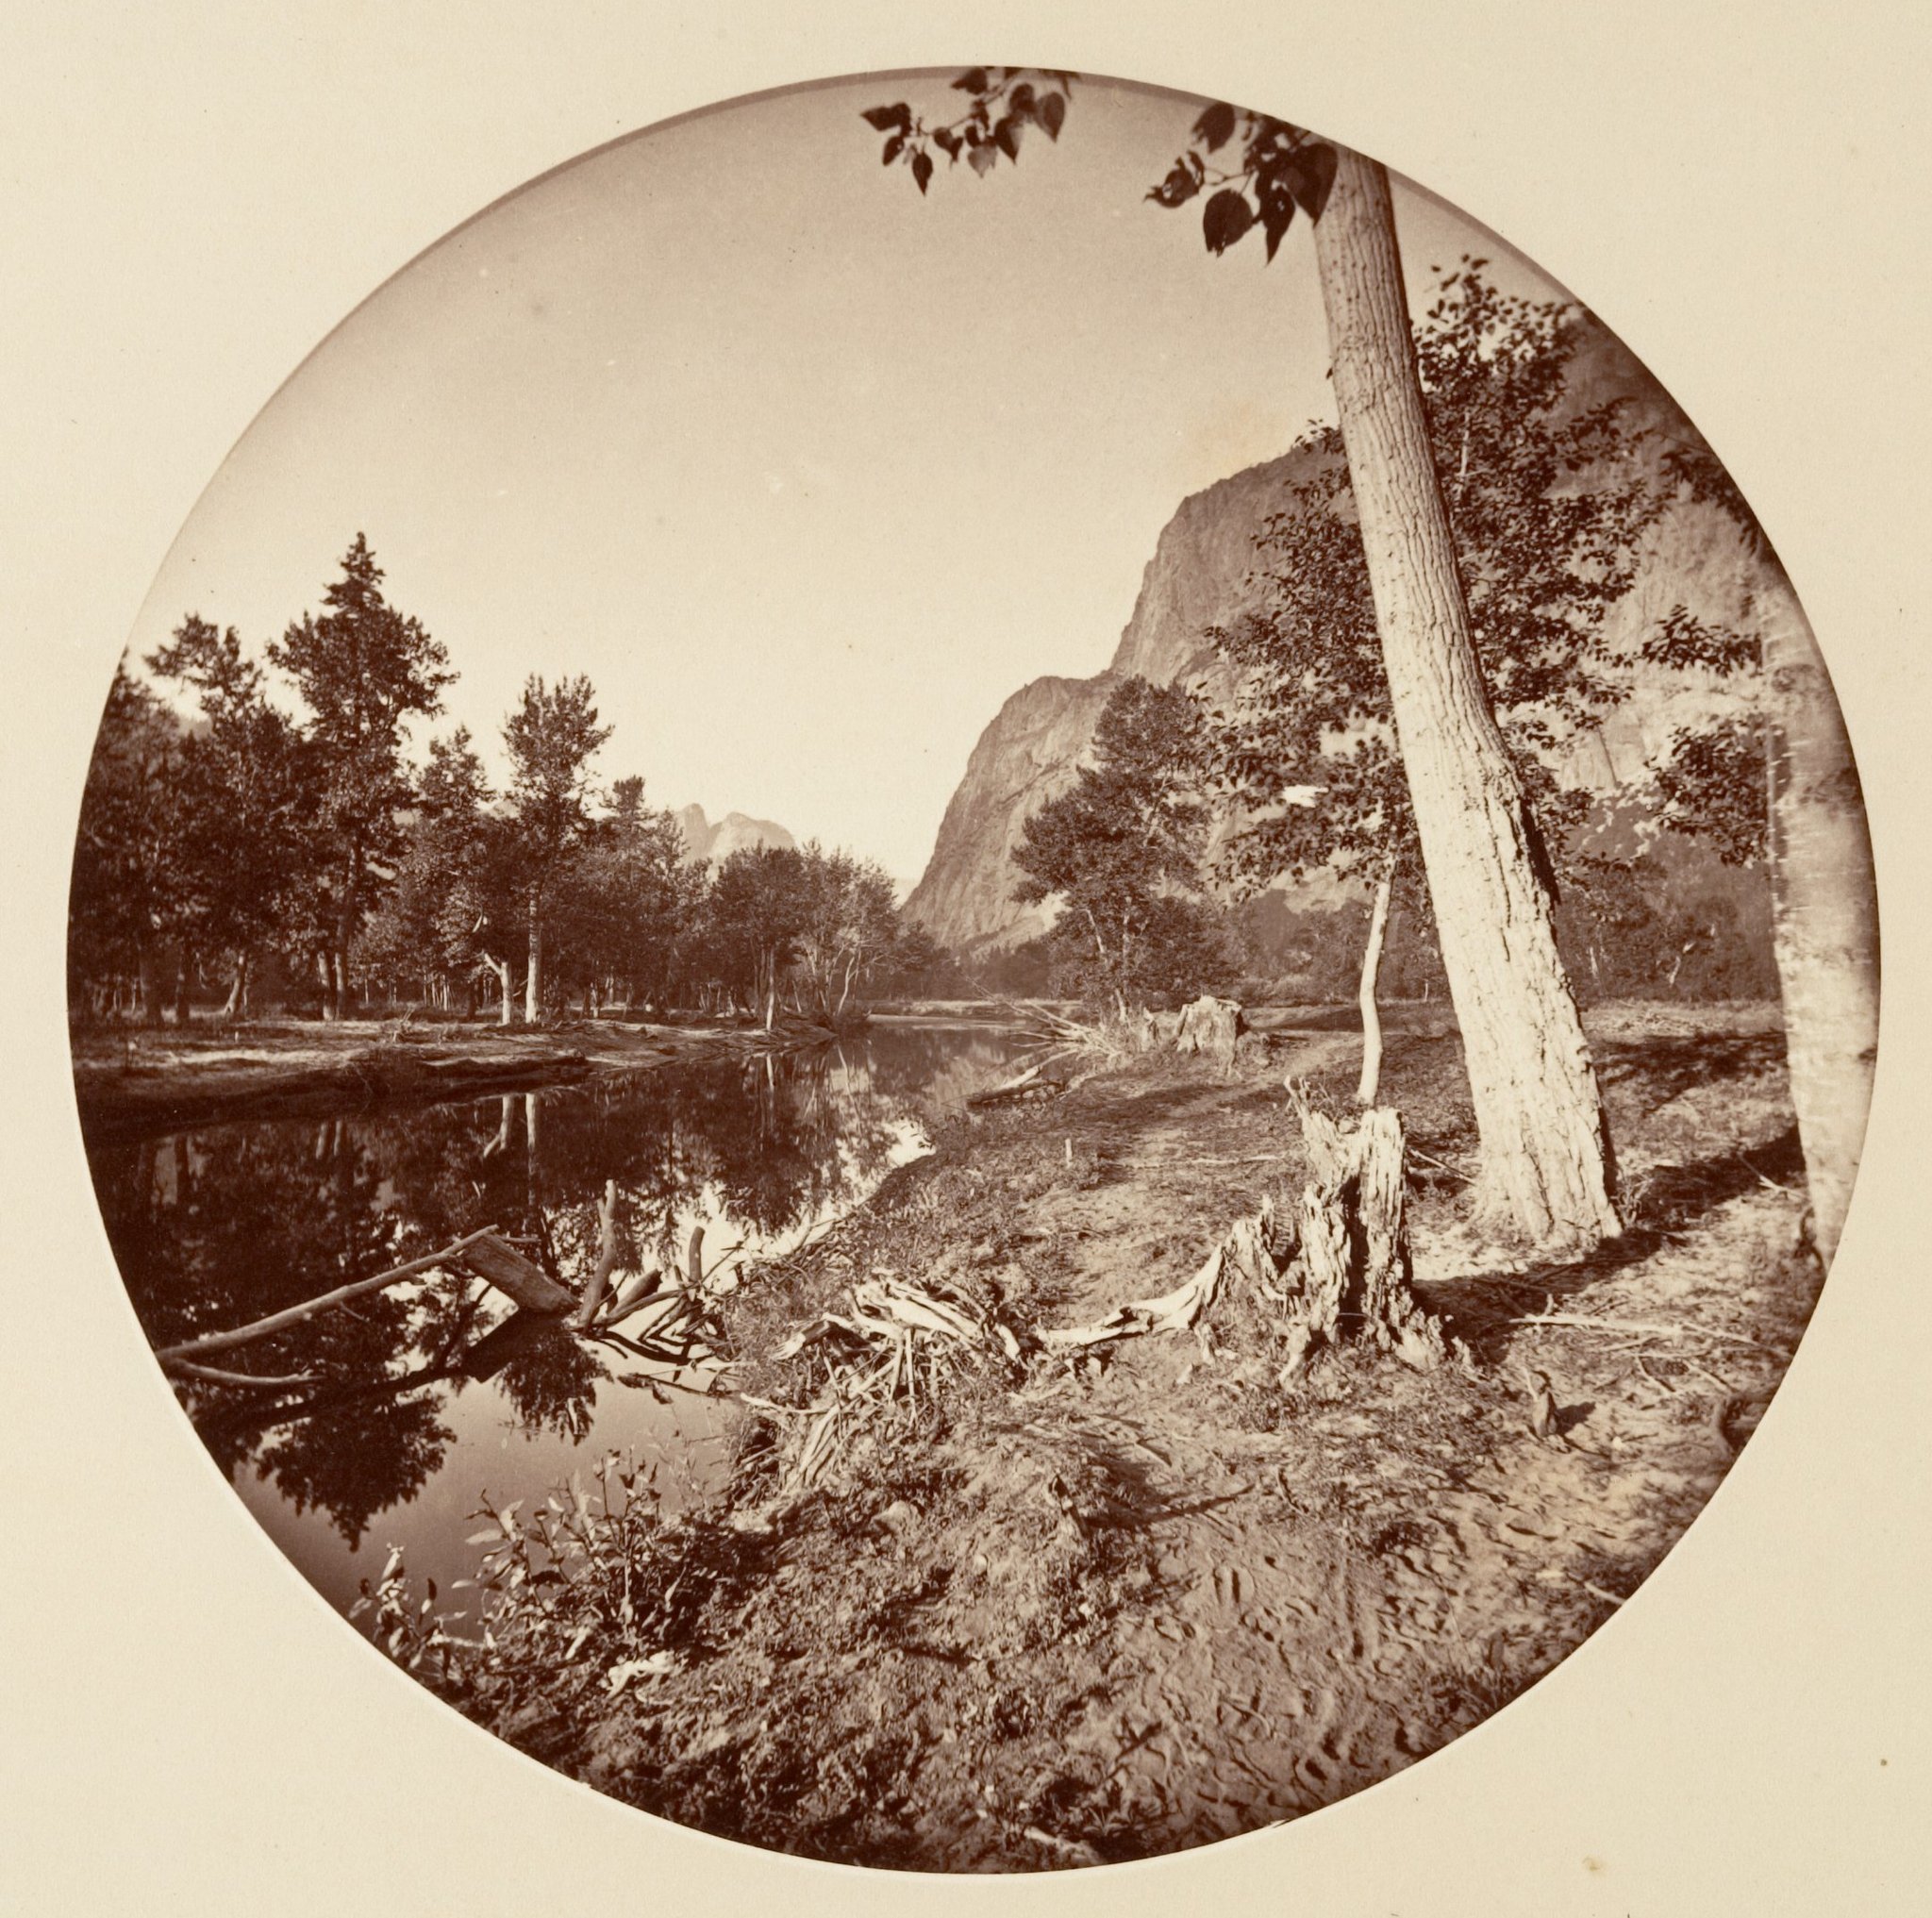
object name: photograph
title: [Yosemite National Park, California]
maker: carleton e. watkins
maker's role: artist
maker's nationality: american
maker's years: 1829-1916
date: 1878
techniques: albumen silver print, glass negative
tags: rivers,mountains,landscapes